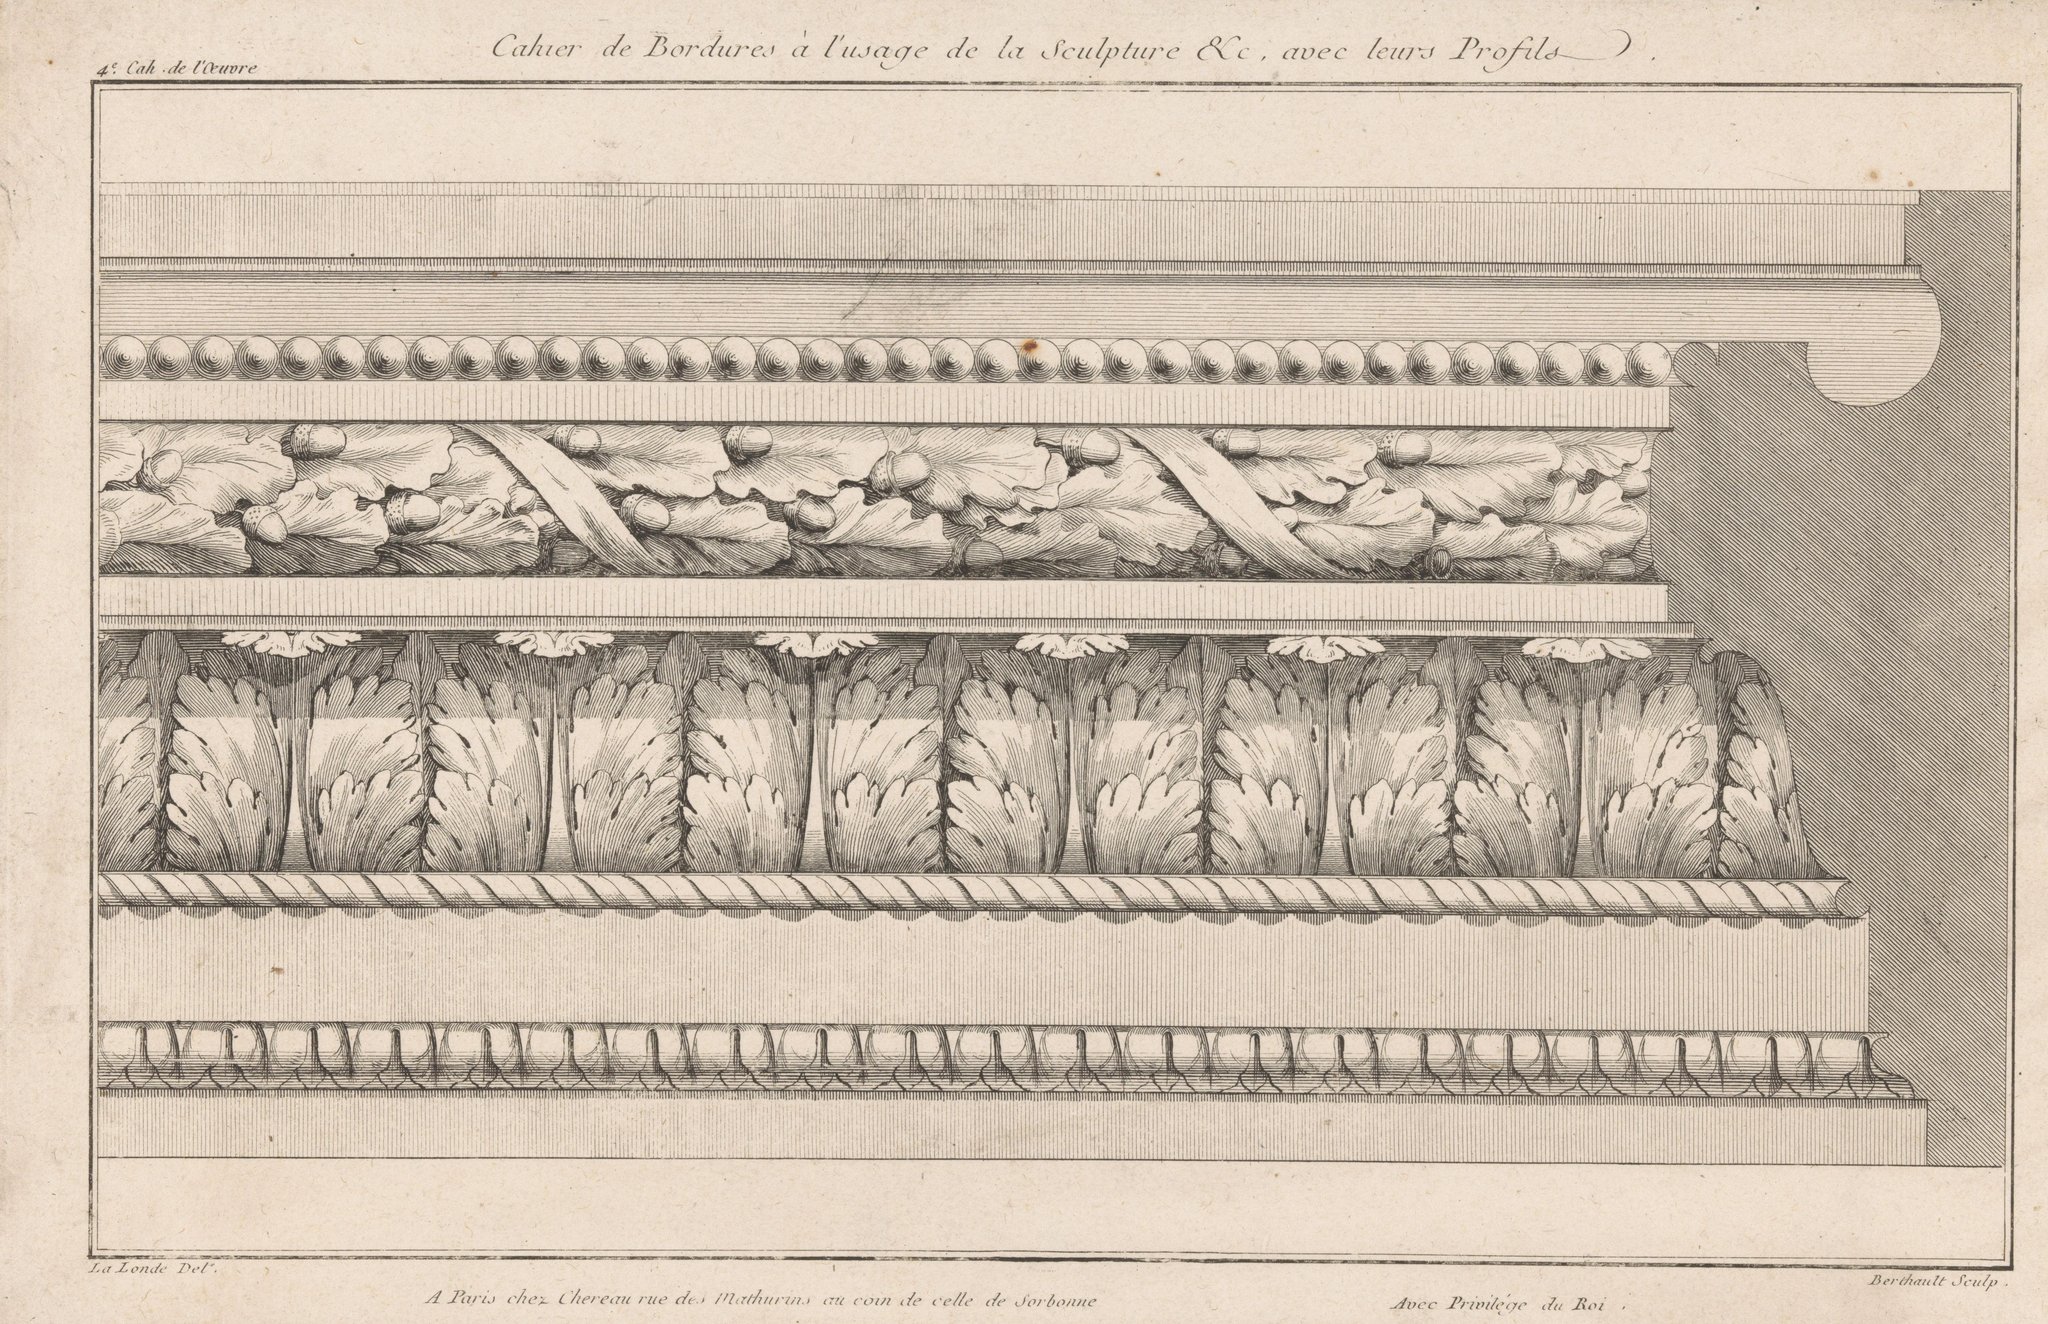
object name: titelprent, frontispice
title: Lijst met eikenbladeren en acanthusbladeren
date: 1784-1785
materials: paper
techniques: engraving, etching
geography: paris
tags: ornaments ~ art (+ framing decorations)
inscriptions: collector's mark: Lugt 2228, collector's mark: Lugt 2760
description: Een geornamenteerde lijst met eikenbladeren en acanthusbladeren.